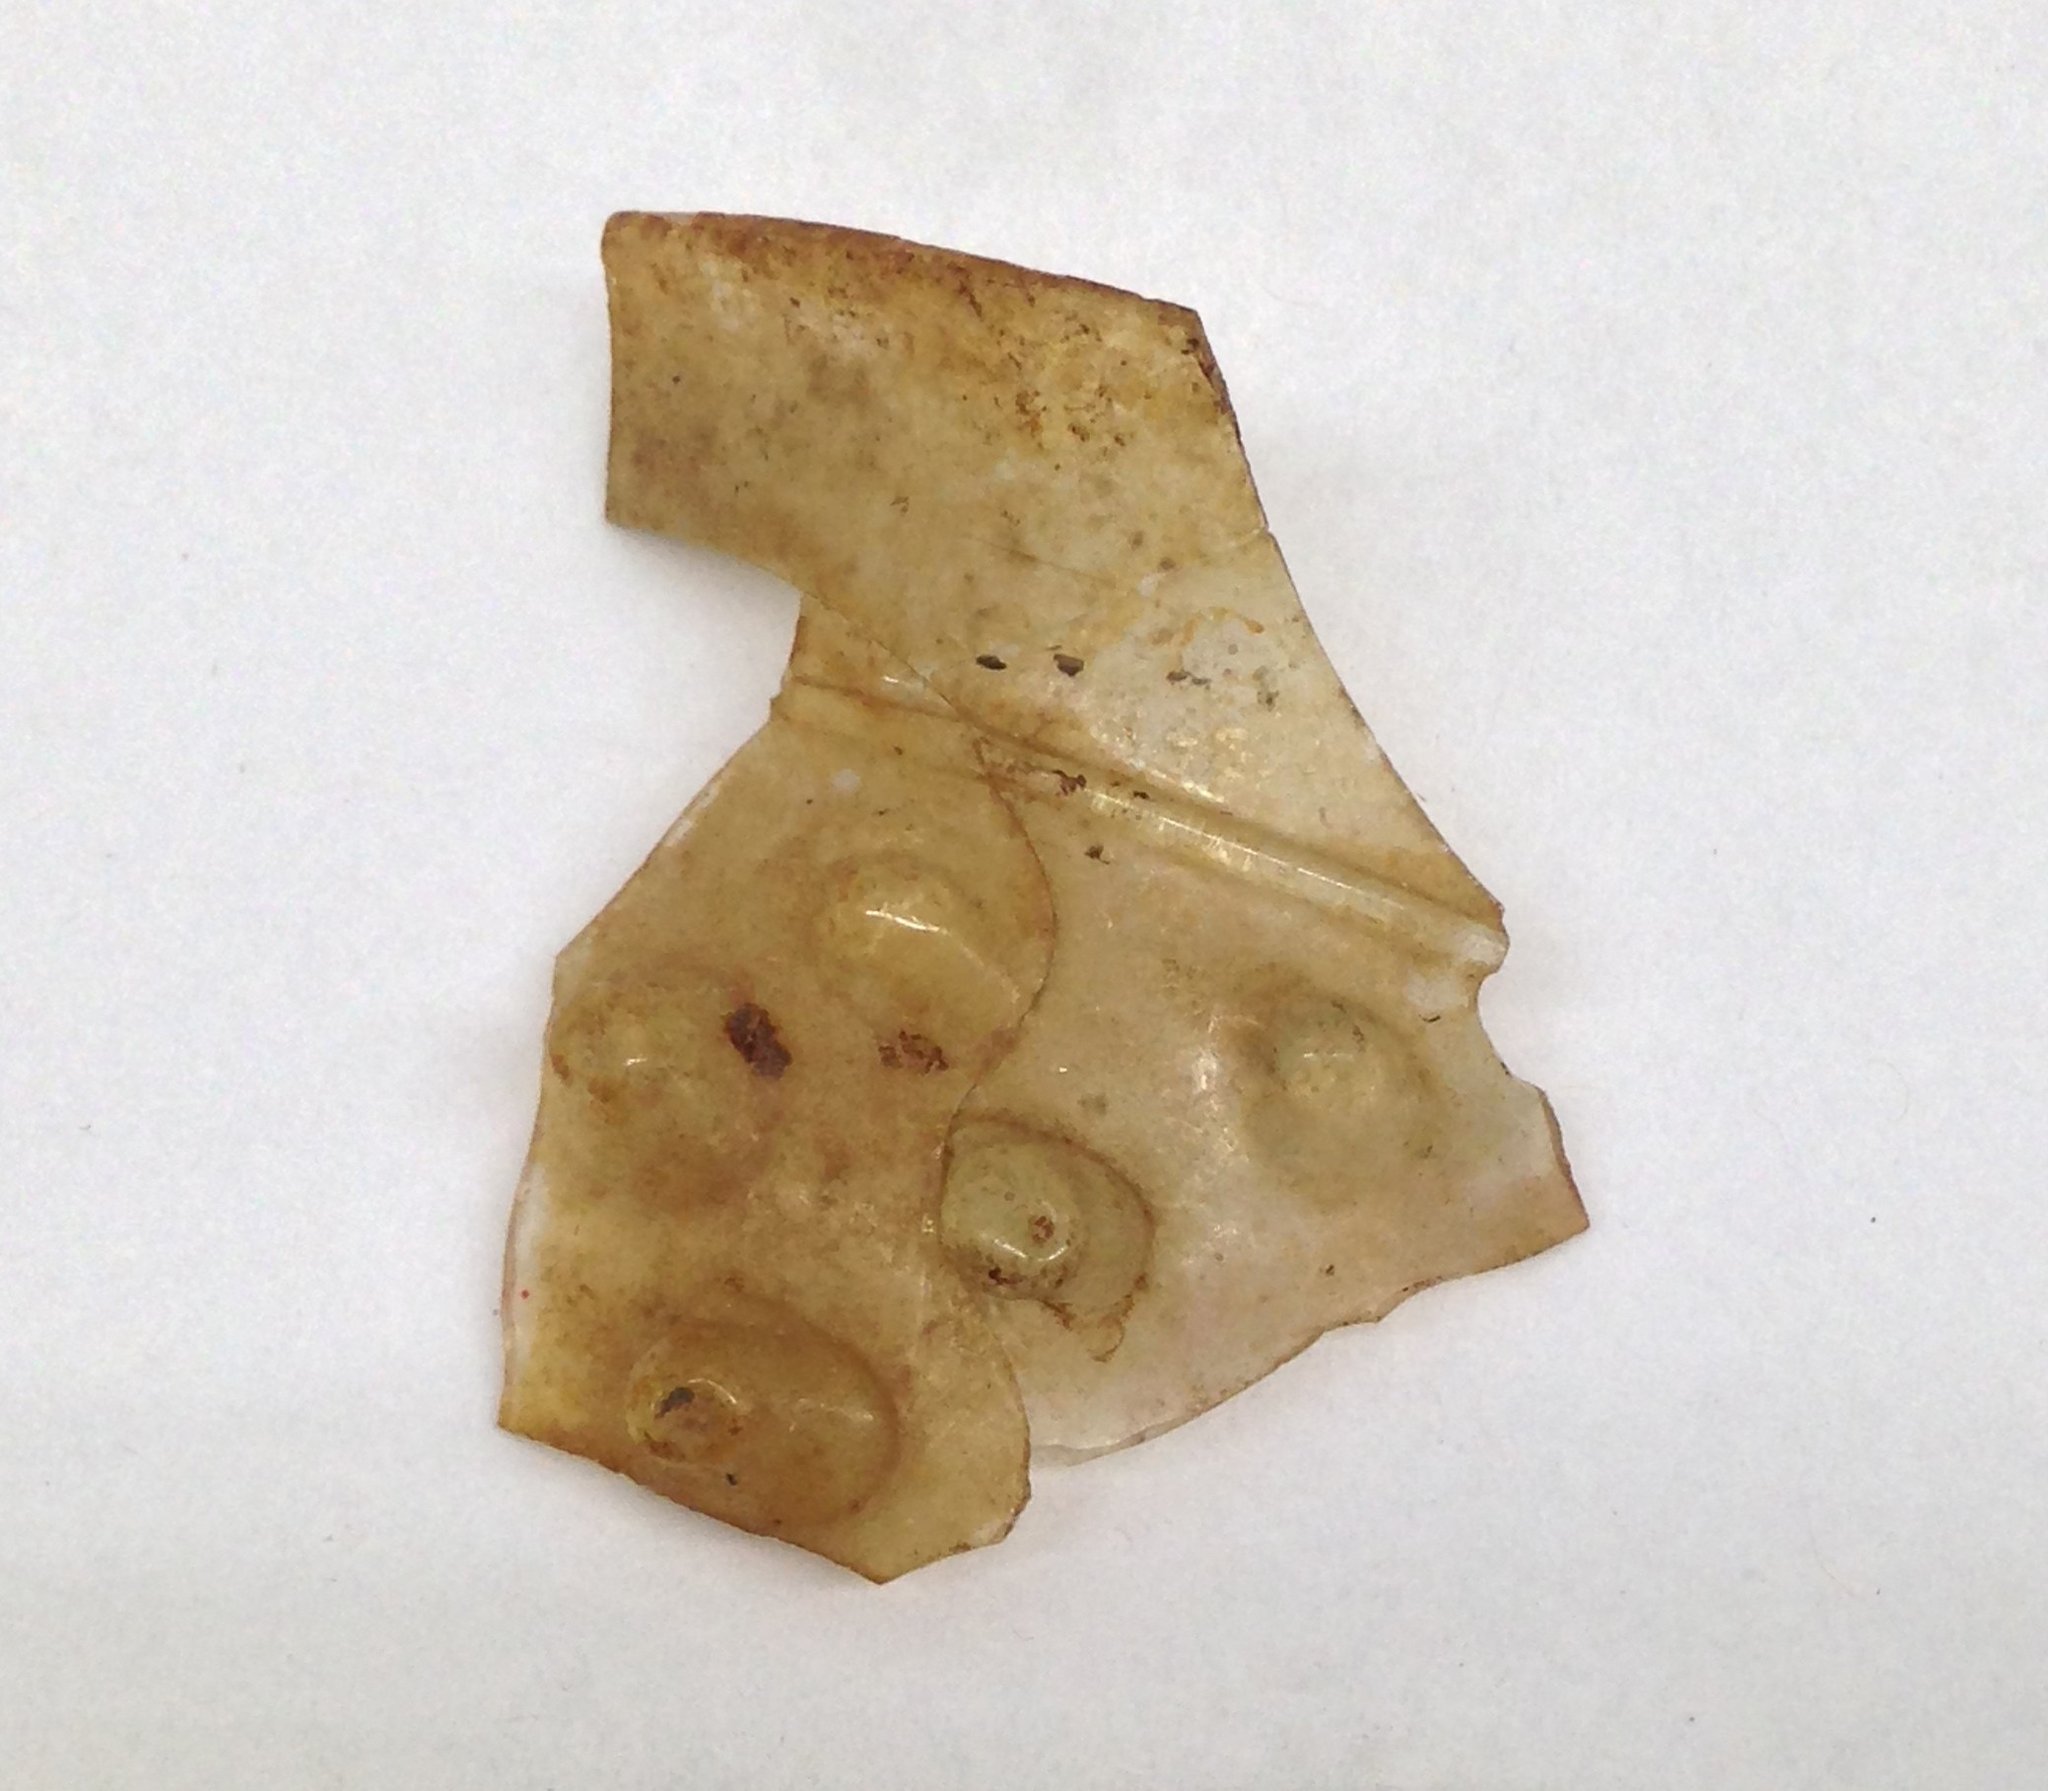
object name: glass vessel fragment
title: Fragments from a Glass Vessel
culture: crusader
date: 1201-1300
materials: glass